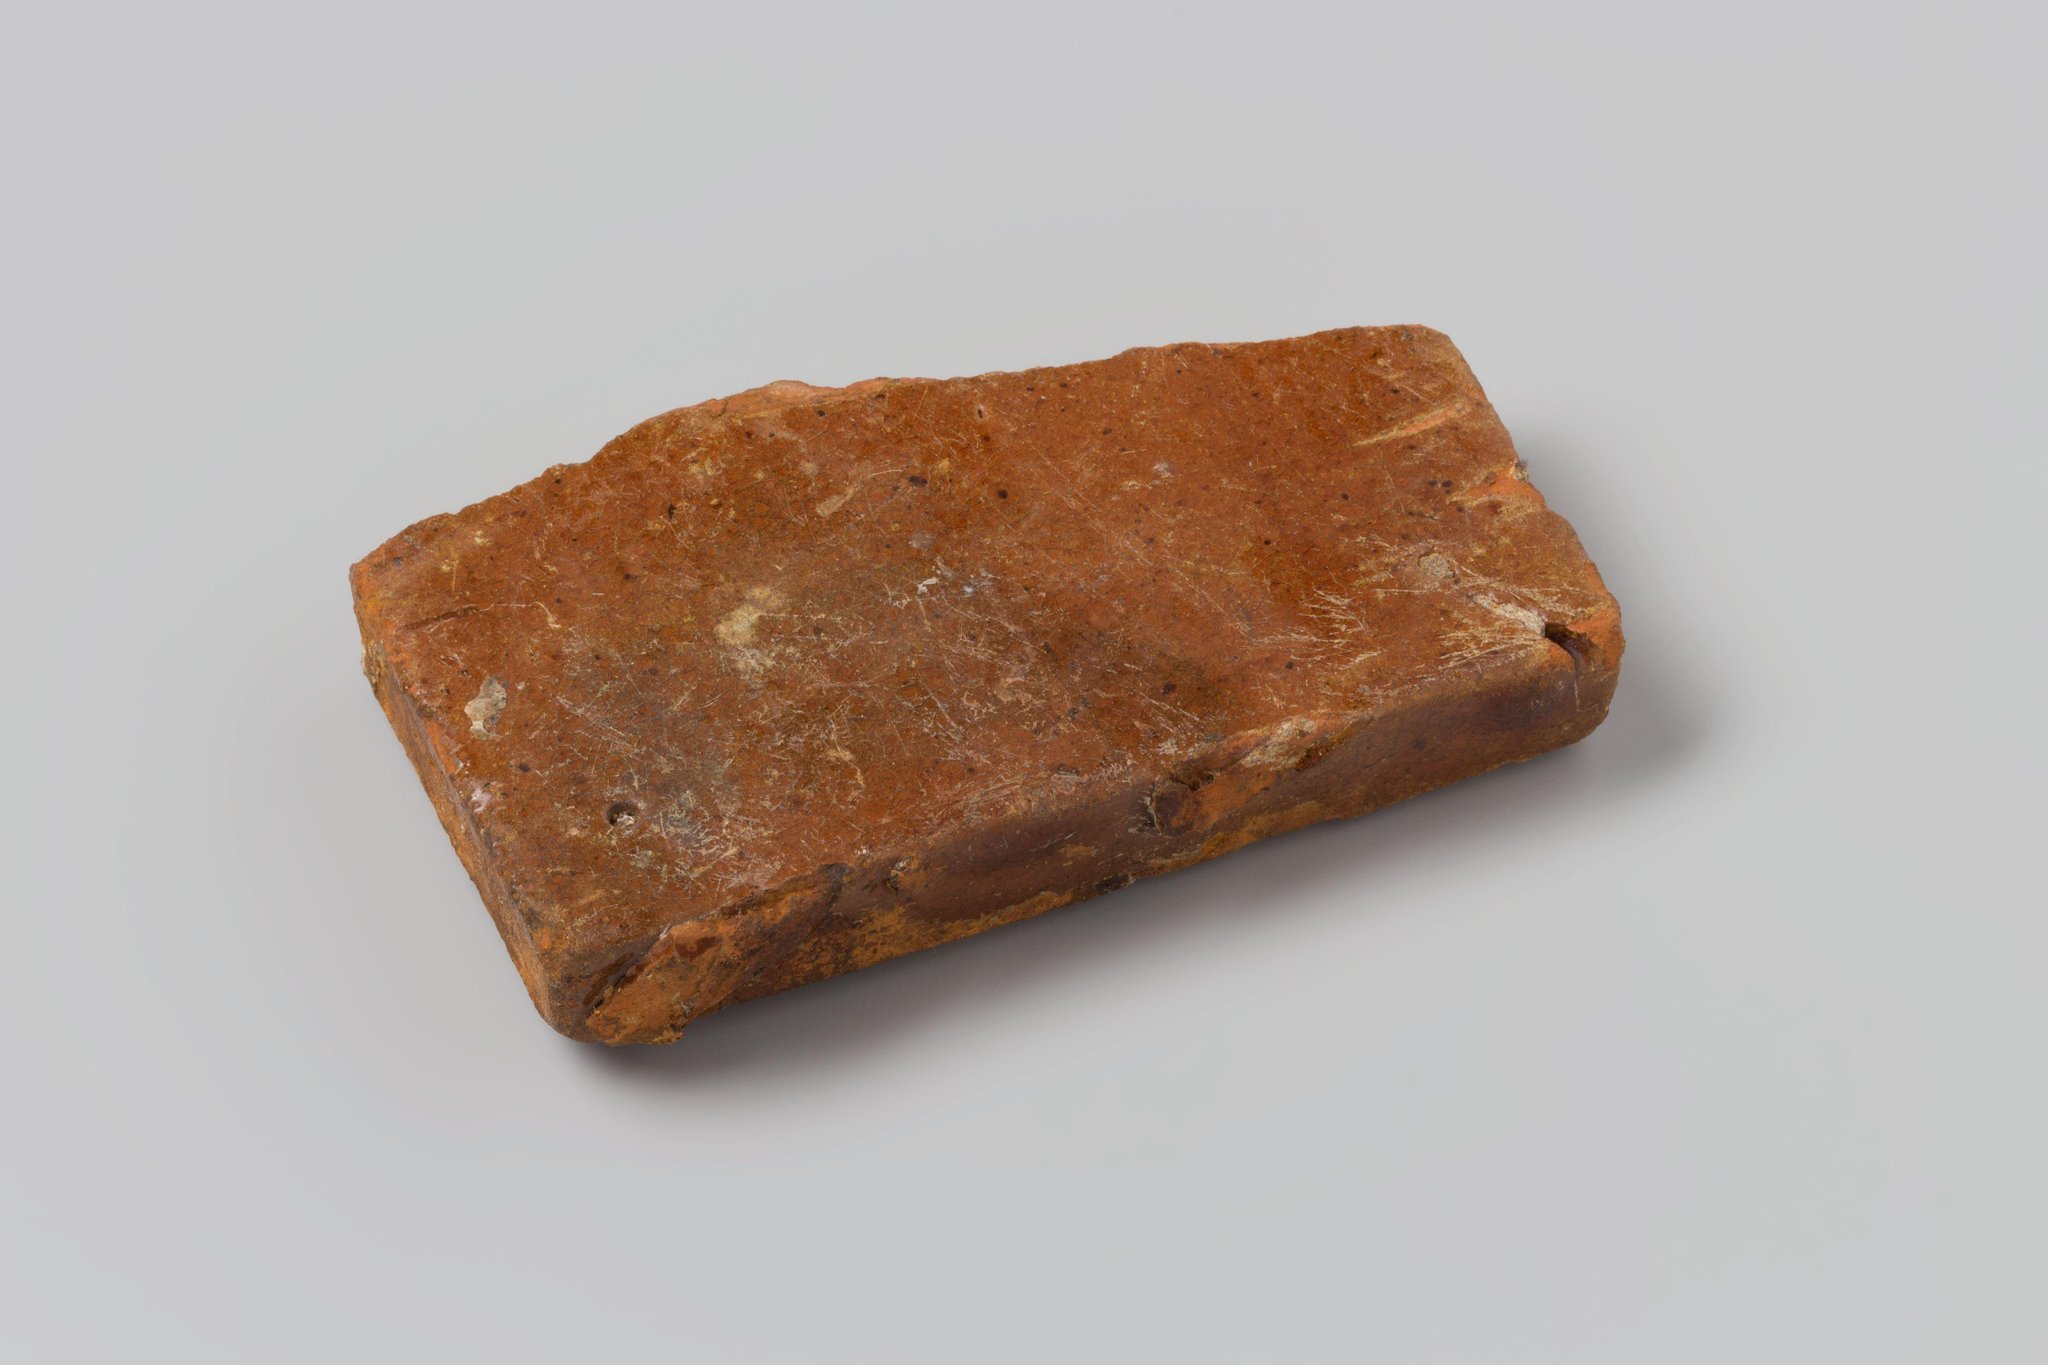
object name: tile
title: Fragment tegel uit het wrak van de Oost-Indiëvaarder Hollandia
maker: Anonymous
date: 1700-1743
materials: earthenware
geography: netherlands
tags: verenigde oostindische compagnie, hollandia (schip), annet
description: Tile; fragm, rectangular, flat, red-glazed.